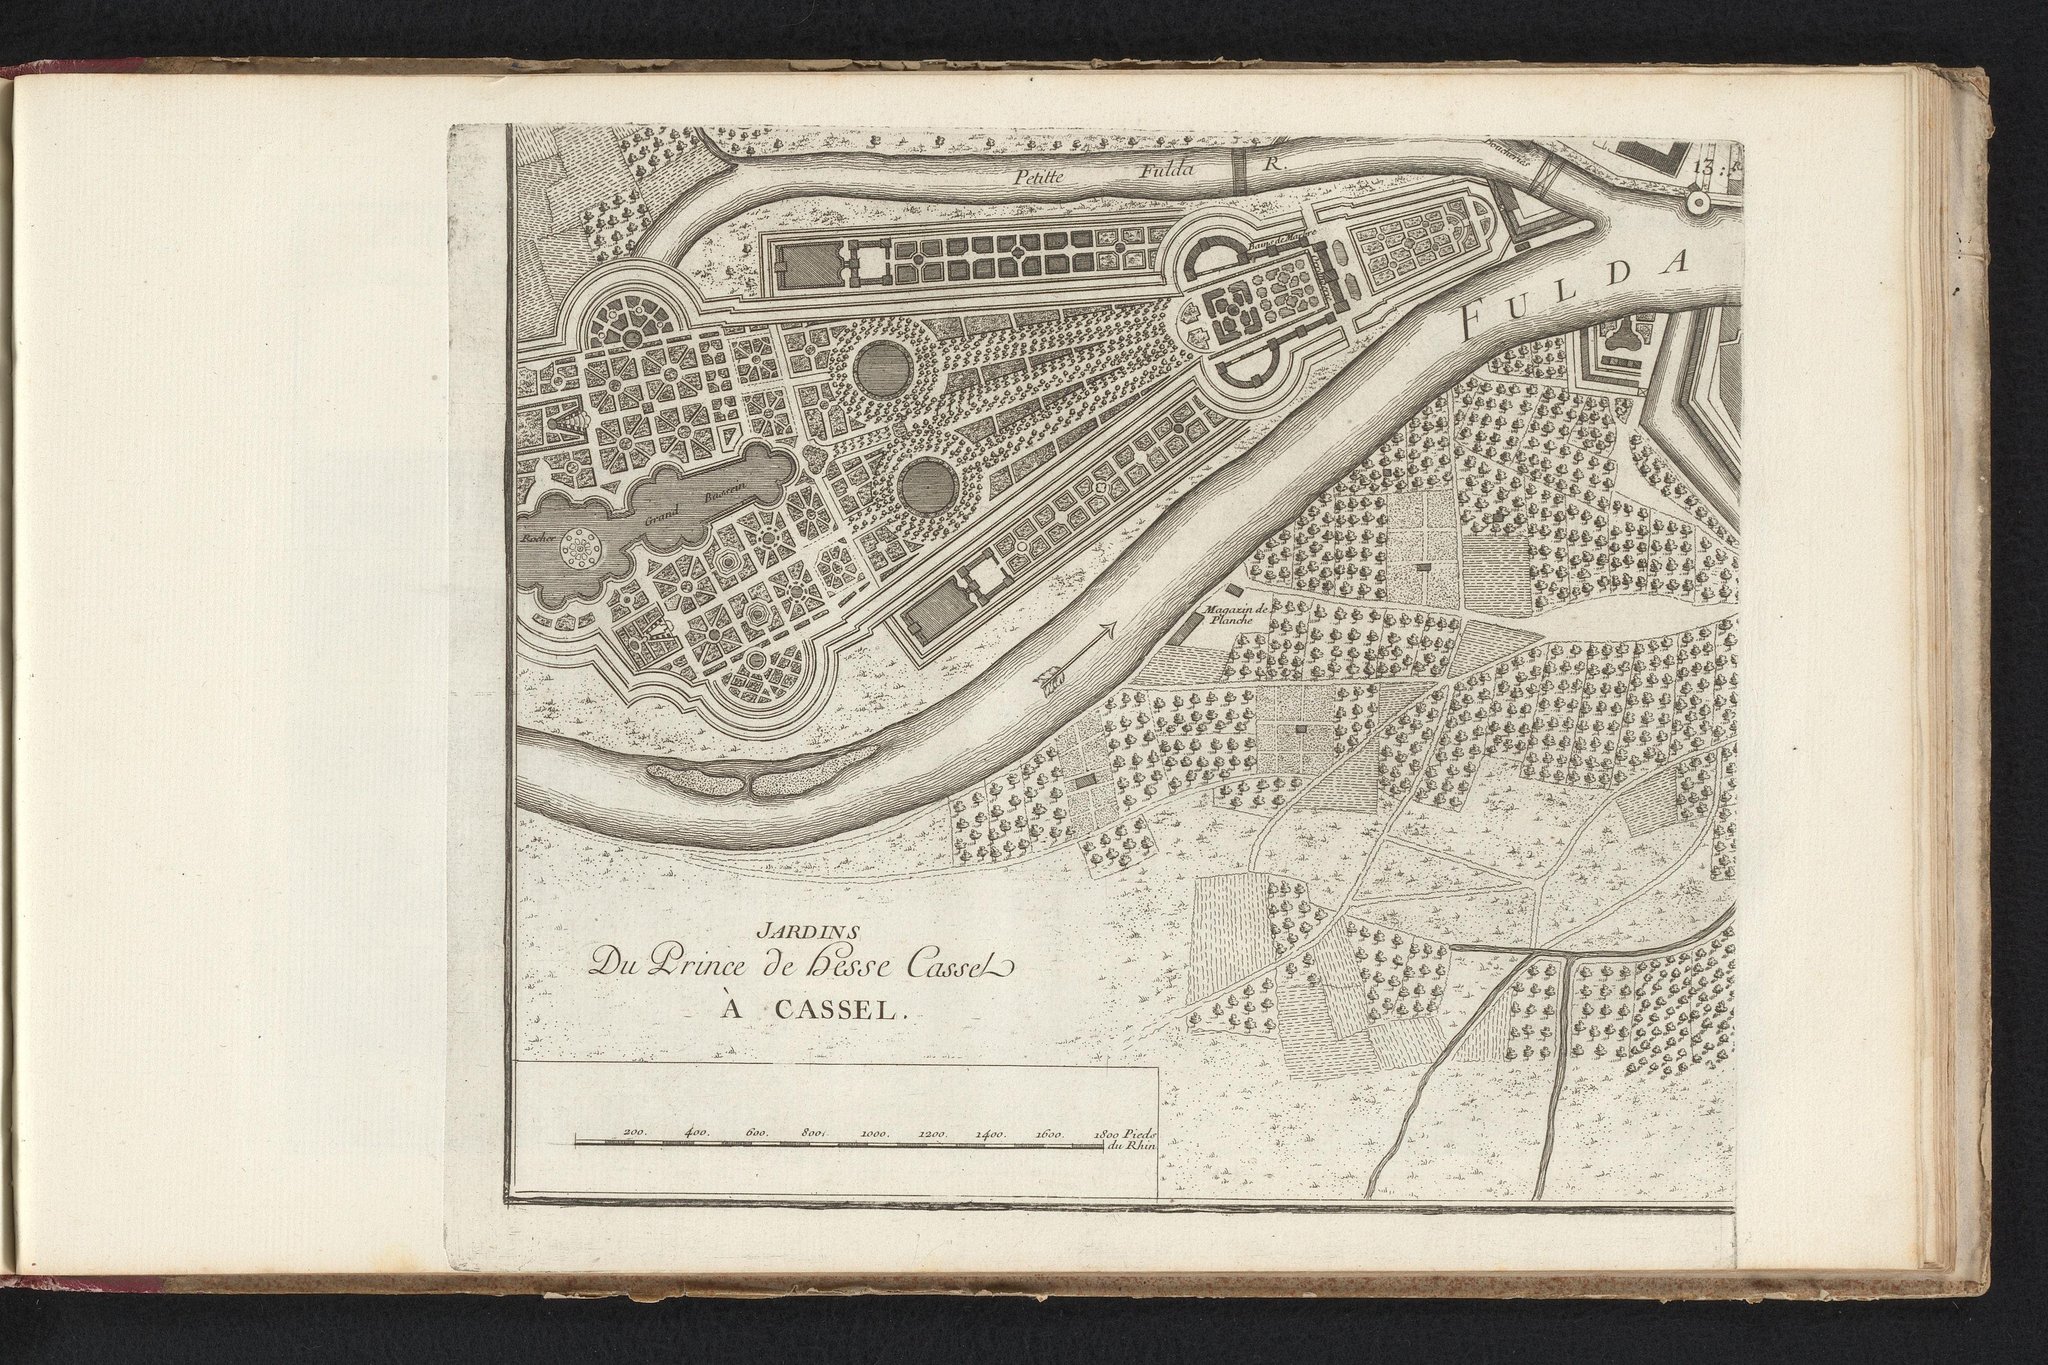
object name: print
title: Jardins du prince de Hesse Cassel à Cassel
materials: paper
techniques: engraving, etching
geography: paris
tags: plan, map of garden, lay-out of garden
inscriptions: collector's mark: Lugt 2760, collector's mark: Lugt 2228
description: De serie 'Jardins anglo-chinois à la mode' verscheen in totaal in 21 zogeheten 'cahiers' (afleveringen). De huidige prent komt uit het vierde 'cahier'. Het Rijksmuseum Amsterdam bezit drie banden met daarin in totaal zes 'cahiers' van deze reeks. In de documentatie wordt verwezen naar een in de bibliotheek van het Rijksmuseum Amsterdam aanwezige facsimile van het complete werk.